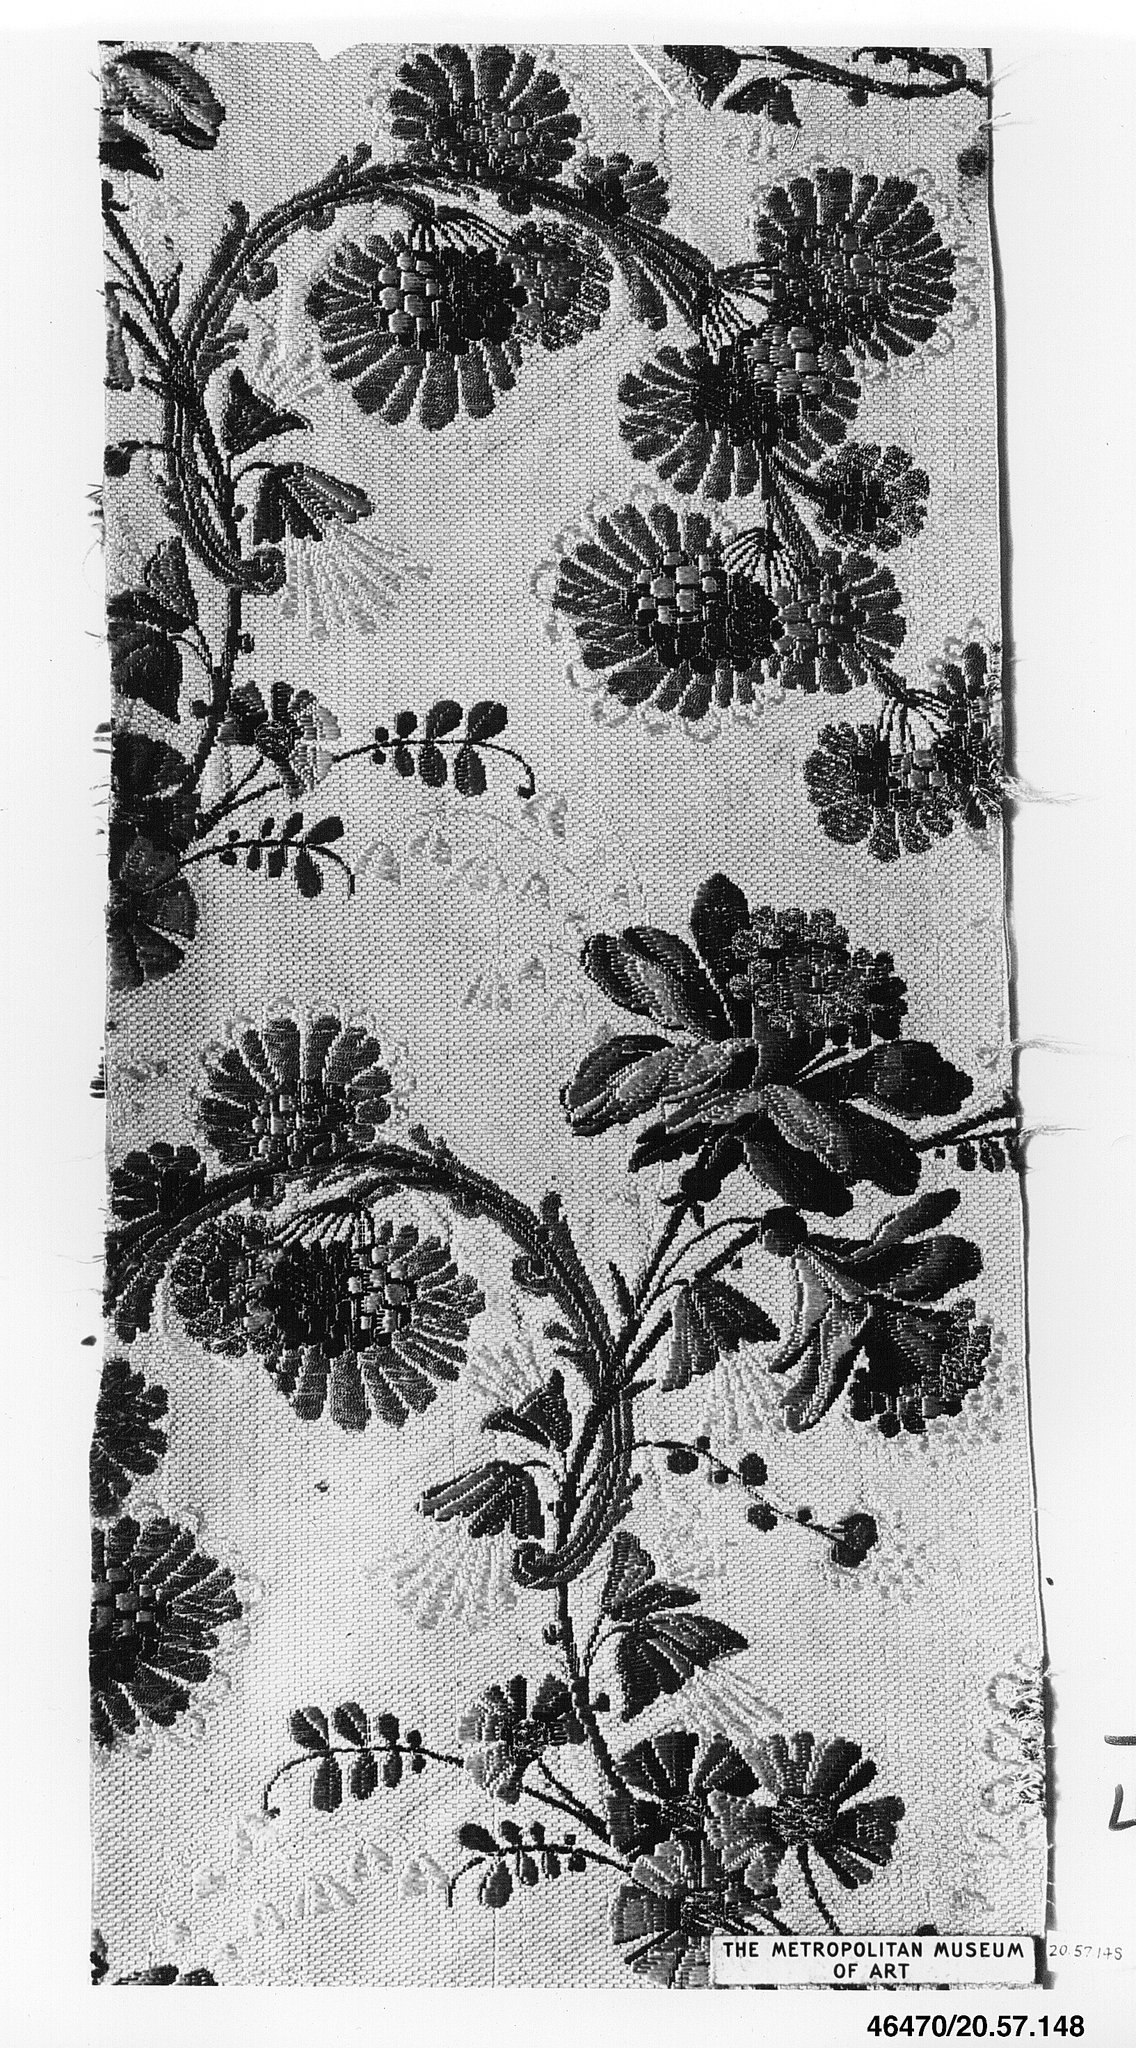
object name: piece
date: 1750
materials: metal thread, silk